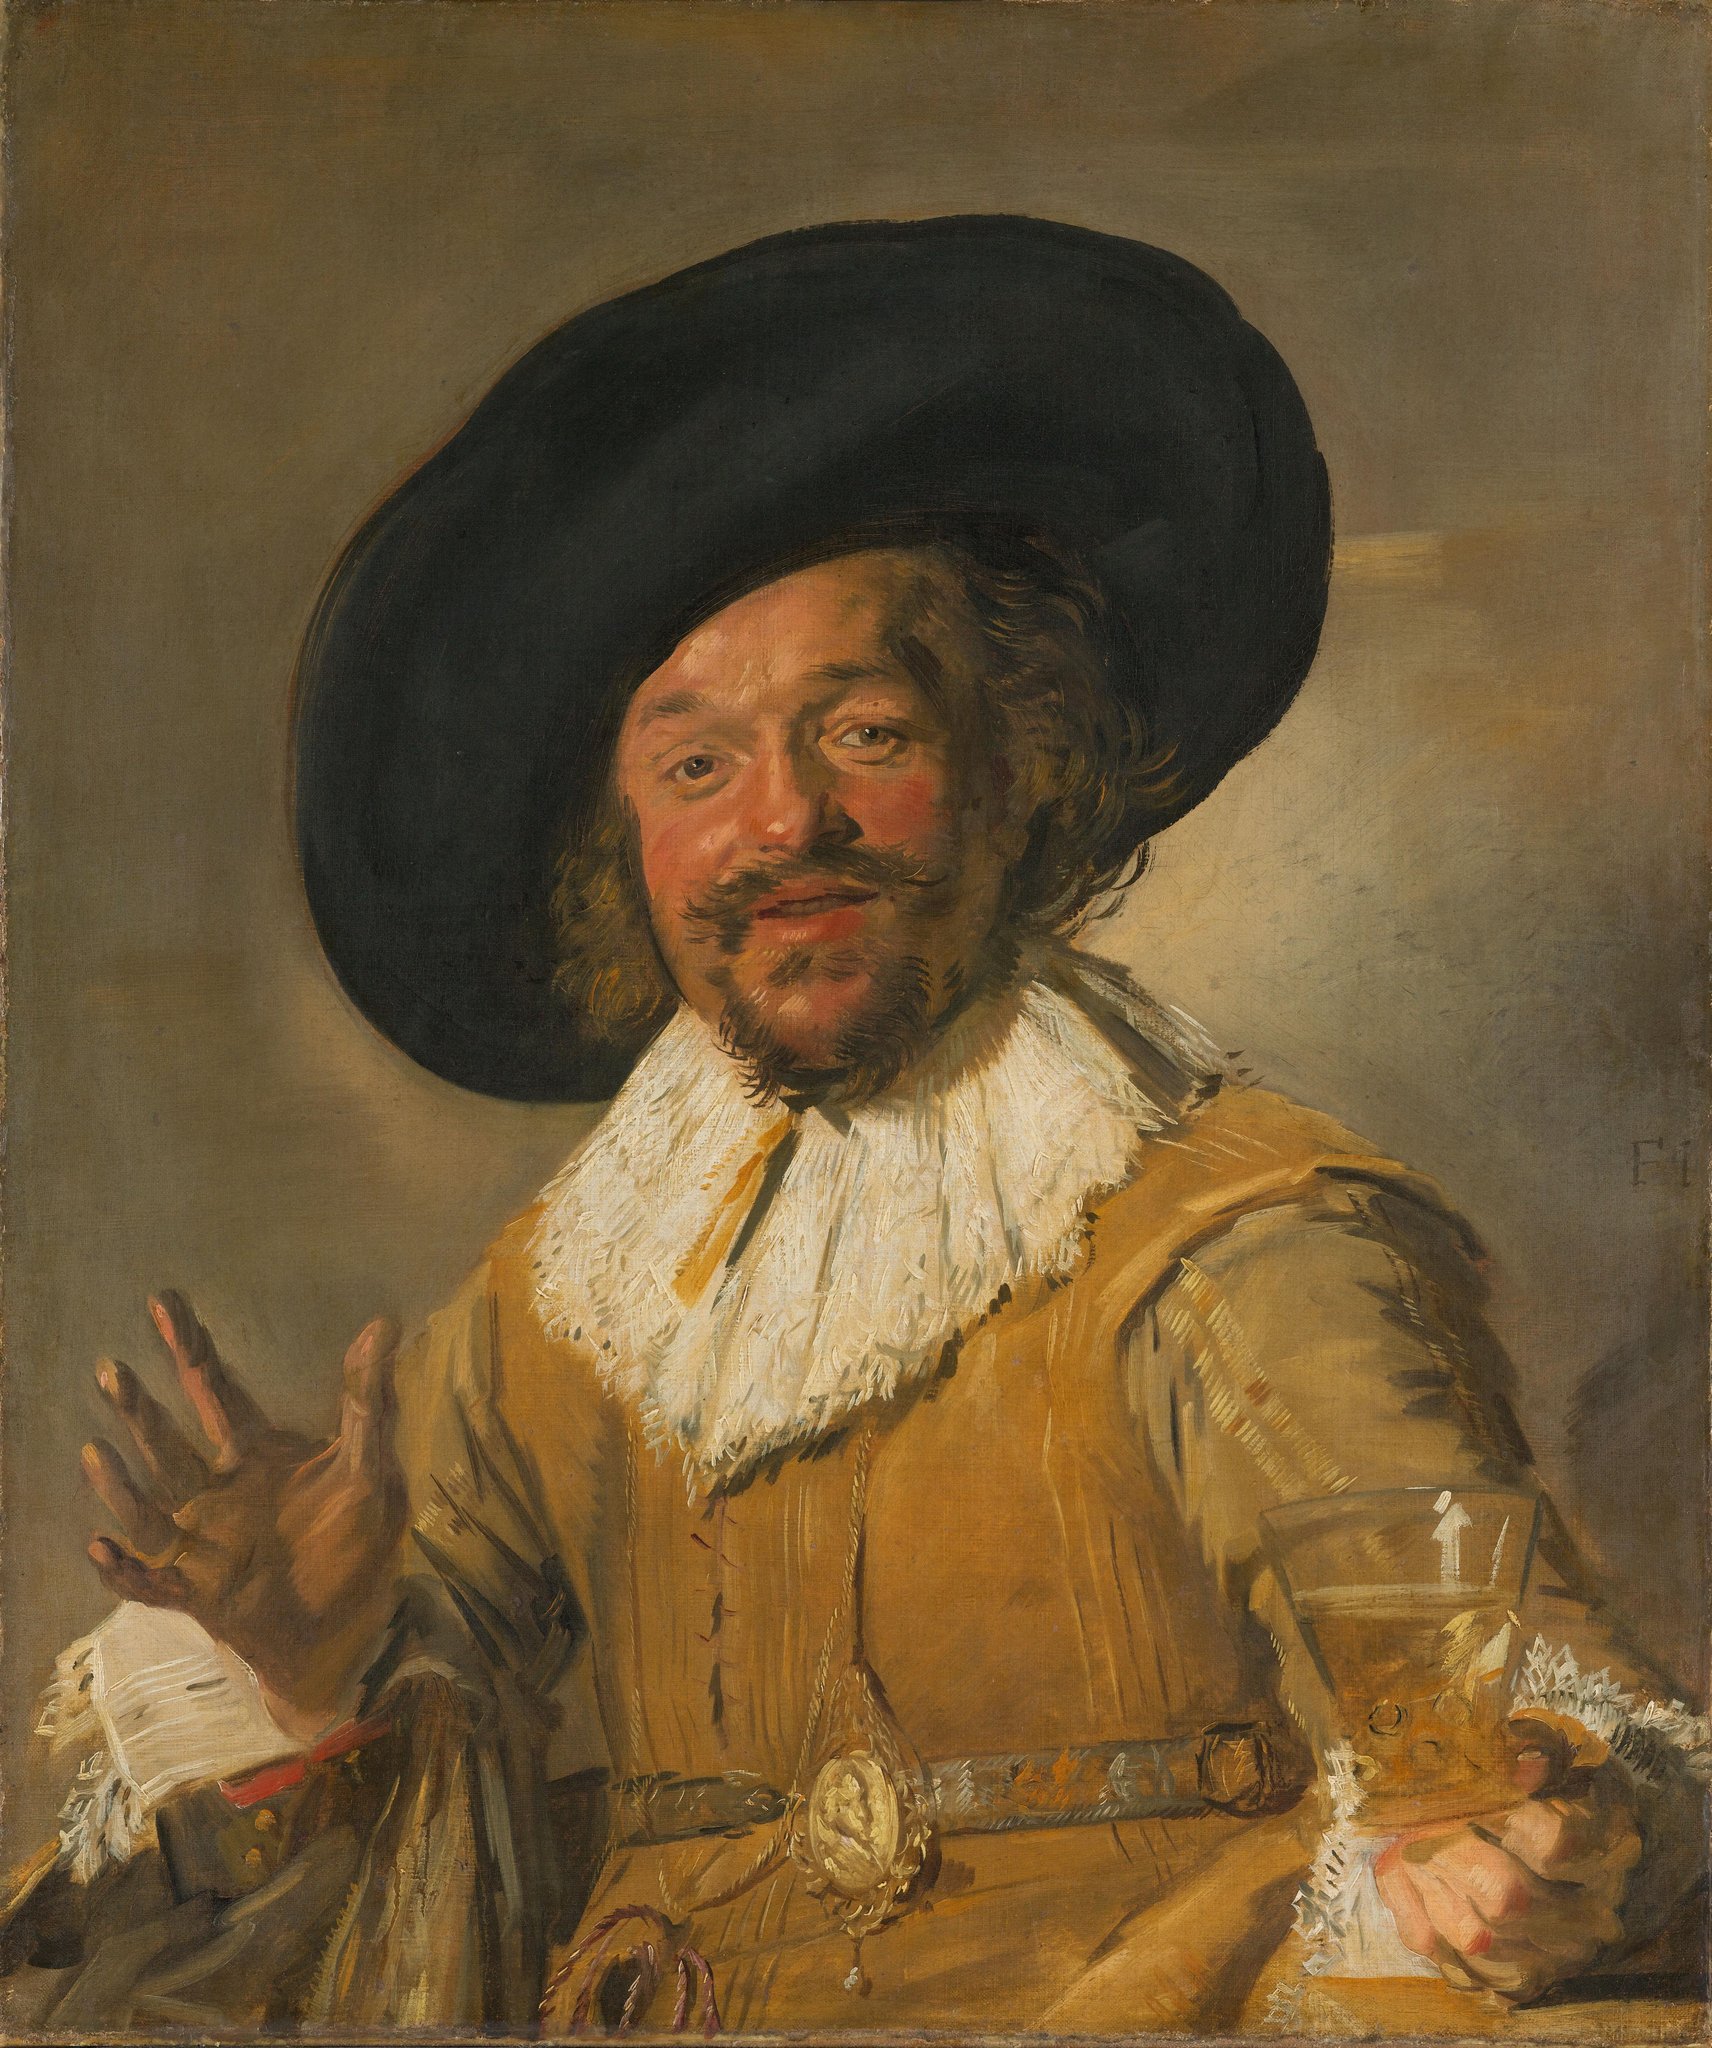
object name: painting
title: The Merry Drinker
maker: frans hals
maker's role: draughtsman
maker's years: 1582-1666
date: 1628-1630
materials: canvas, oil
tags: laughing, head-gear: hat (+ men's clothes), warfare; military affairs (+ citizen soldiery, civil guard, citizen militia), glass, rummer, drinking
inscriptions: signature, ligated monogram, centre right: ‘FH’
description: This work is a pinnacle of Hals’ bold and loose ‘rough’ style. The brushstrokes criss-cross the canvas, creating the impression of rapid execution as well as suggesting movement. The sitter, likely a civic guardsman or a military man based on his attire, is just about to raise his glass to toast with us.